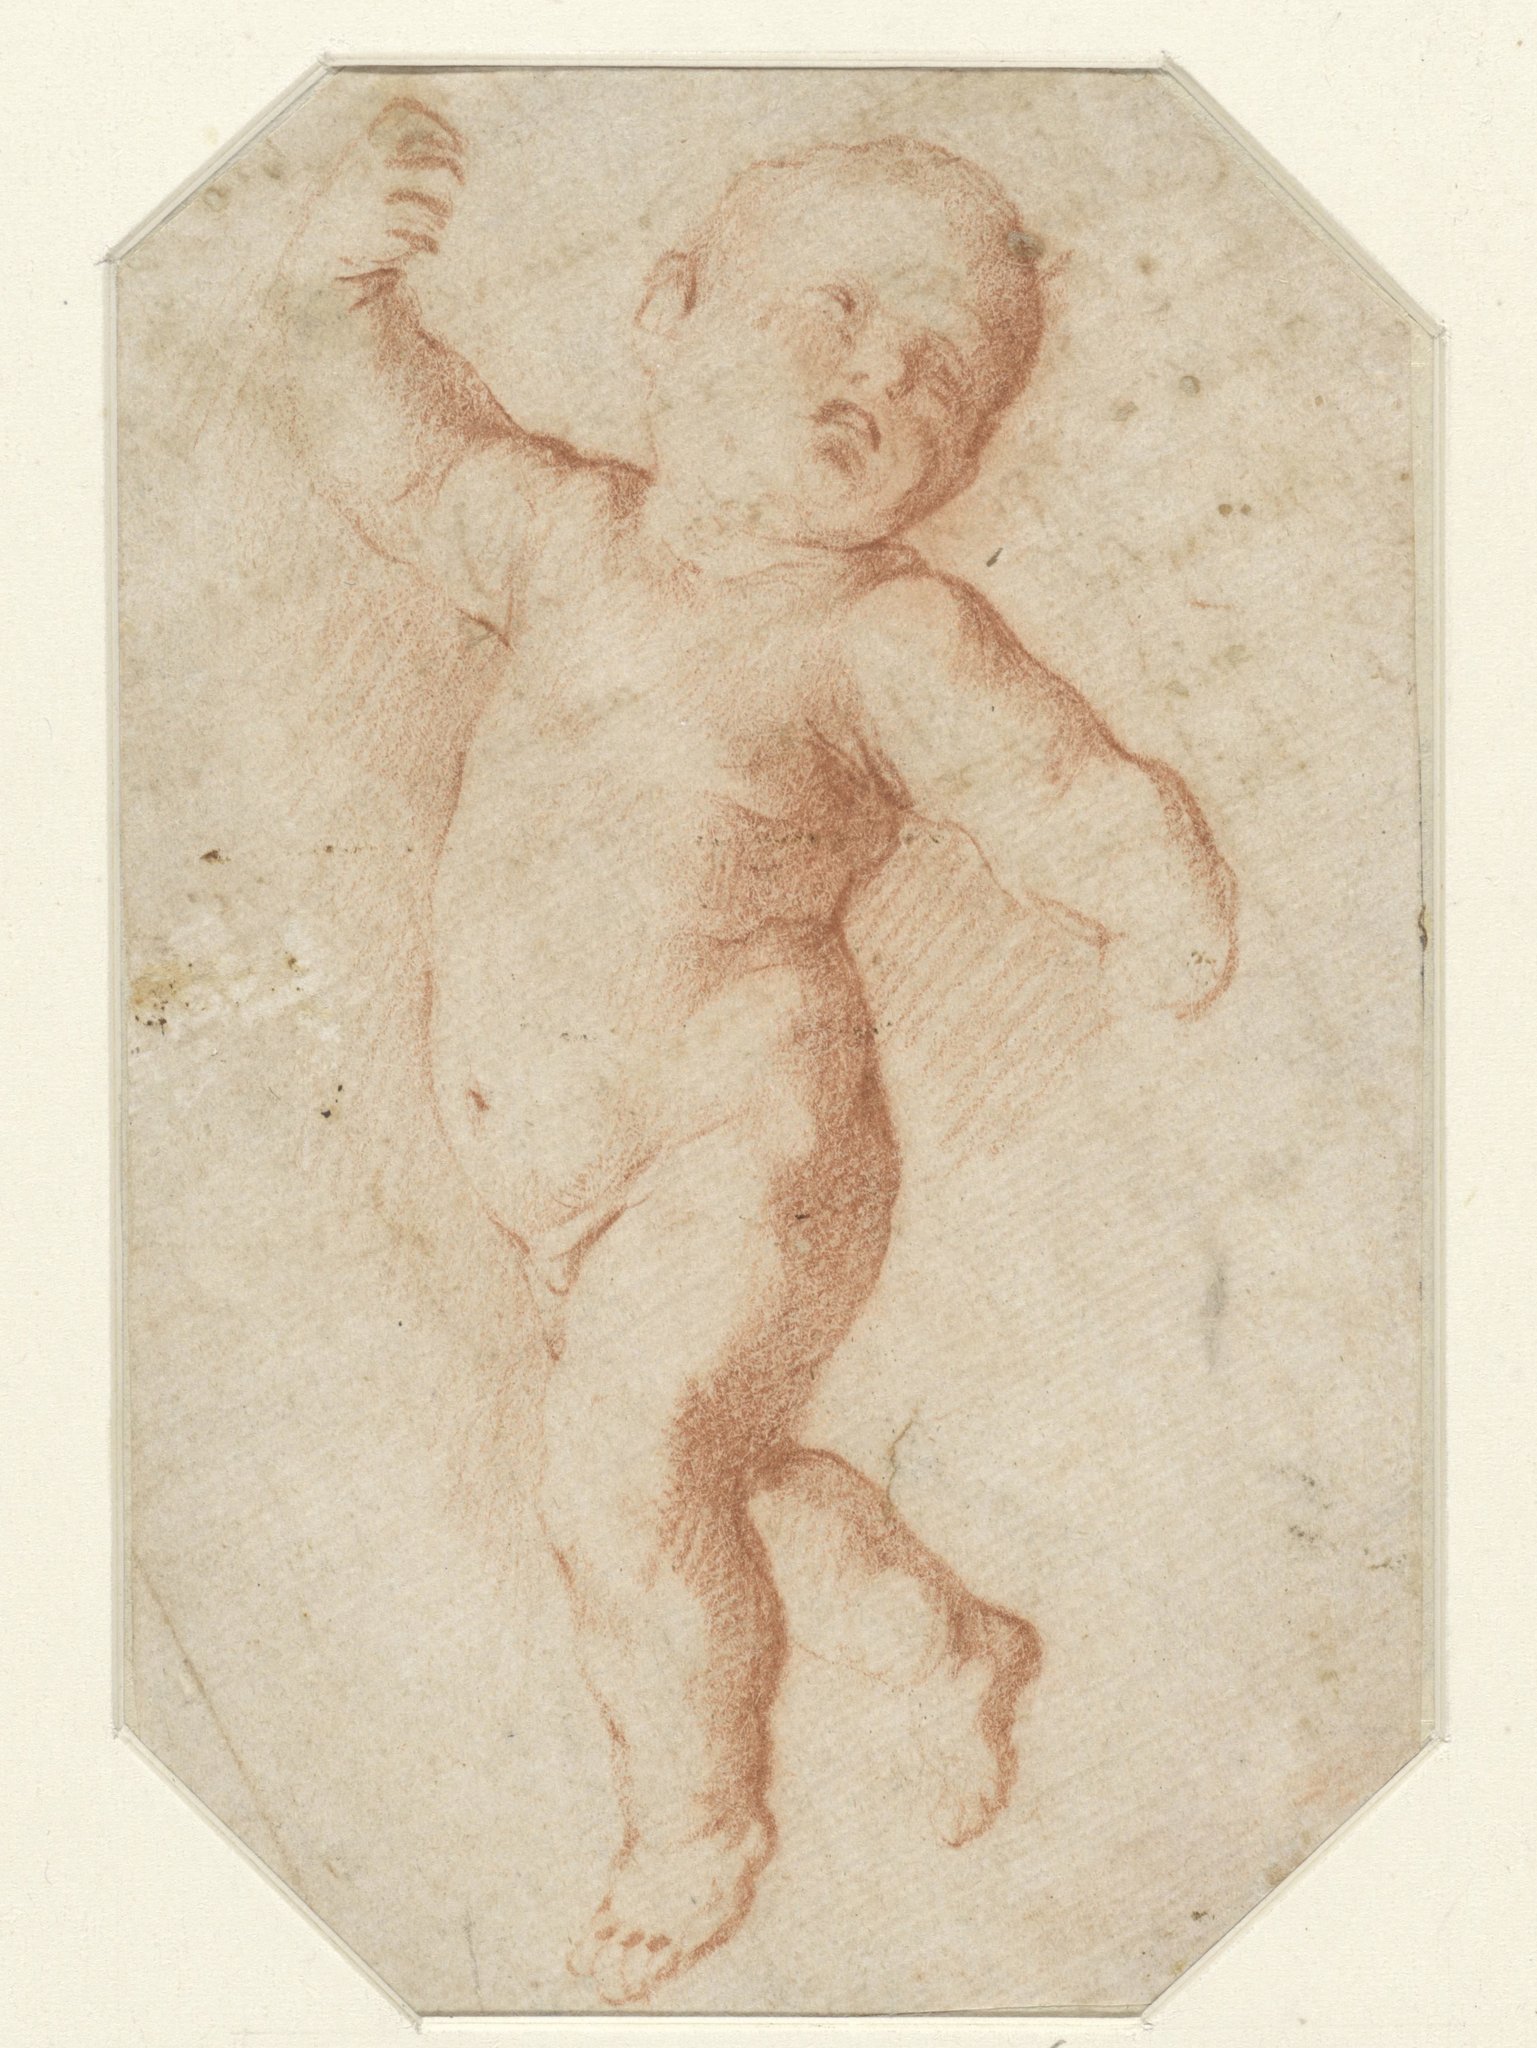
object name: drawing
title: Zwevende putto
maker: bartolomeo schedoni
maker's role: draughtsman, print maker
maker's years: 1578-1615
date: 1588-1615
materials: chalk, paper